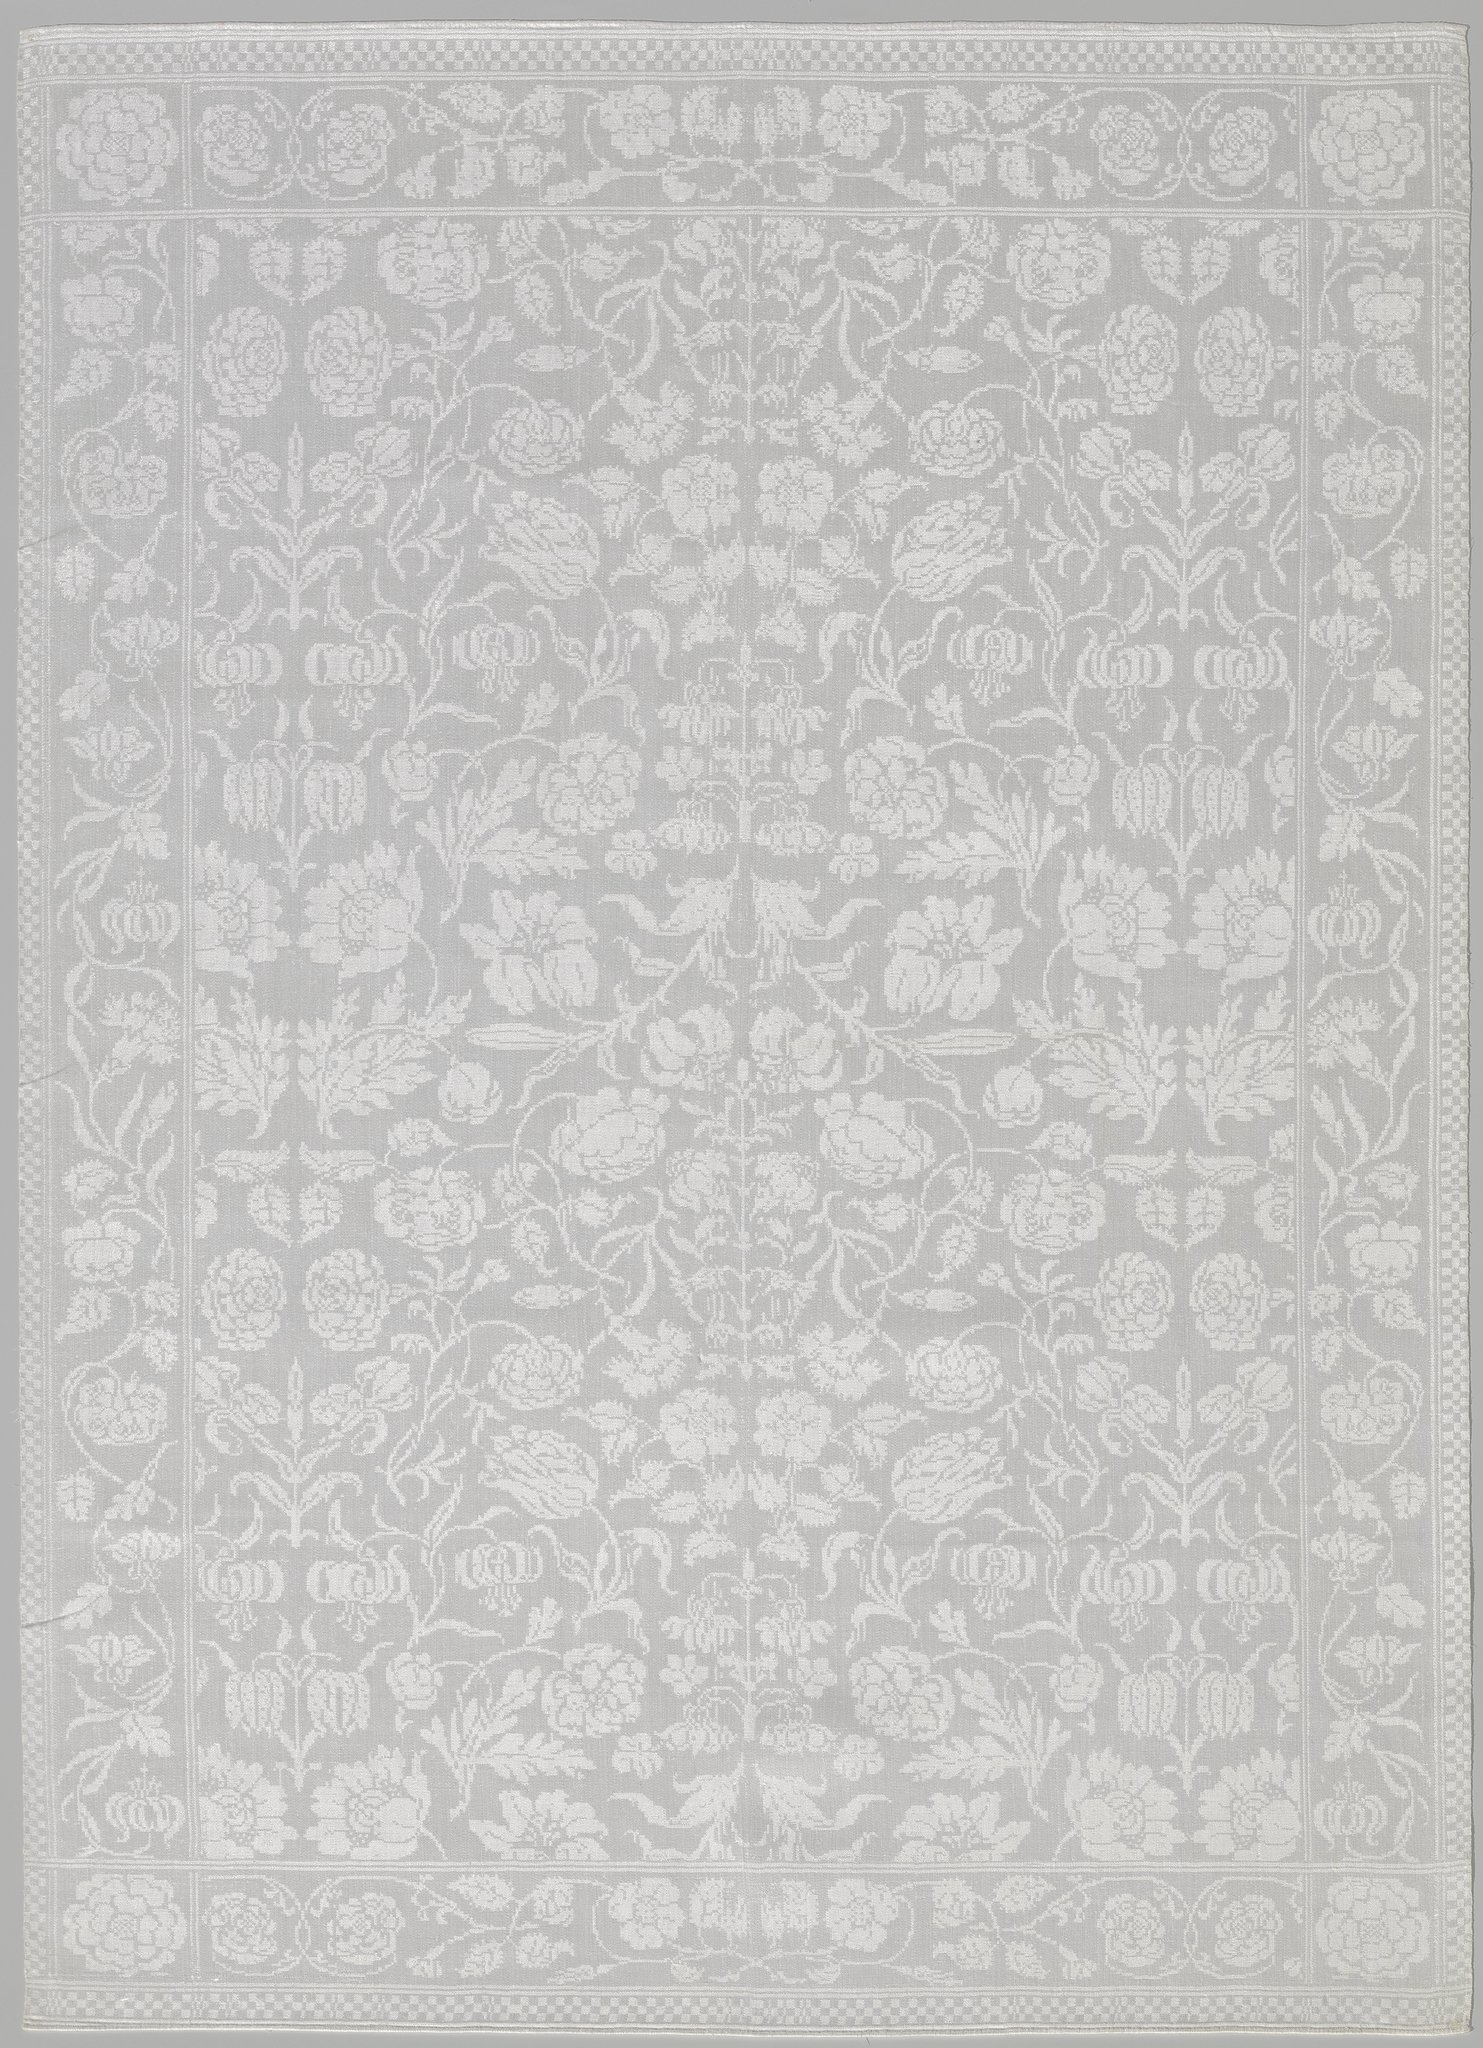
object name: napkin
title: servet met bloemenpatroon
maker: Anonymous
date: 1670-1680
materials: linen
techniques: damask, weave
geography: northern netherlands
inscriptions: mark, mark: ‘12’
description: Wit linnen damasten servet met een patroon van gestrooide bloemen. Merk IG en 12.